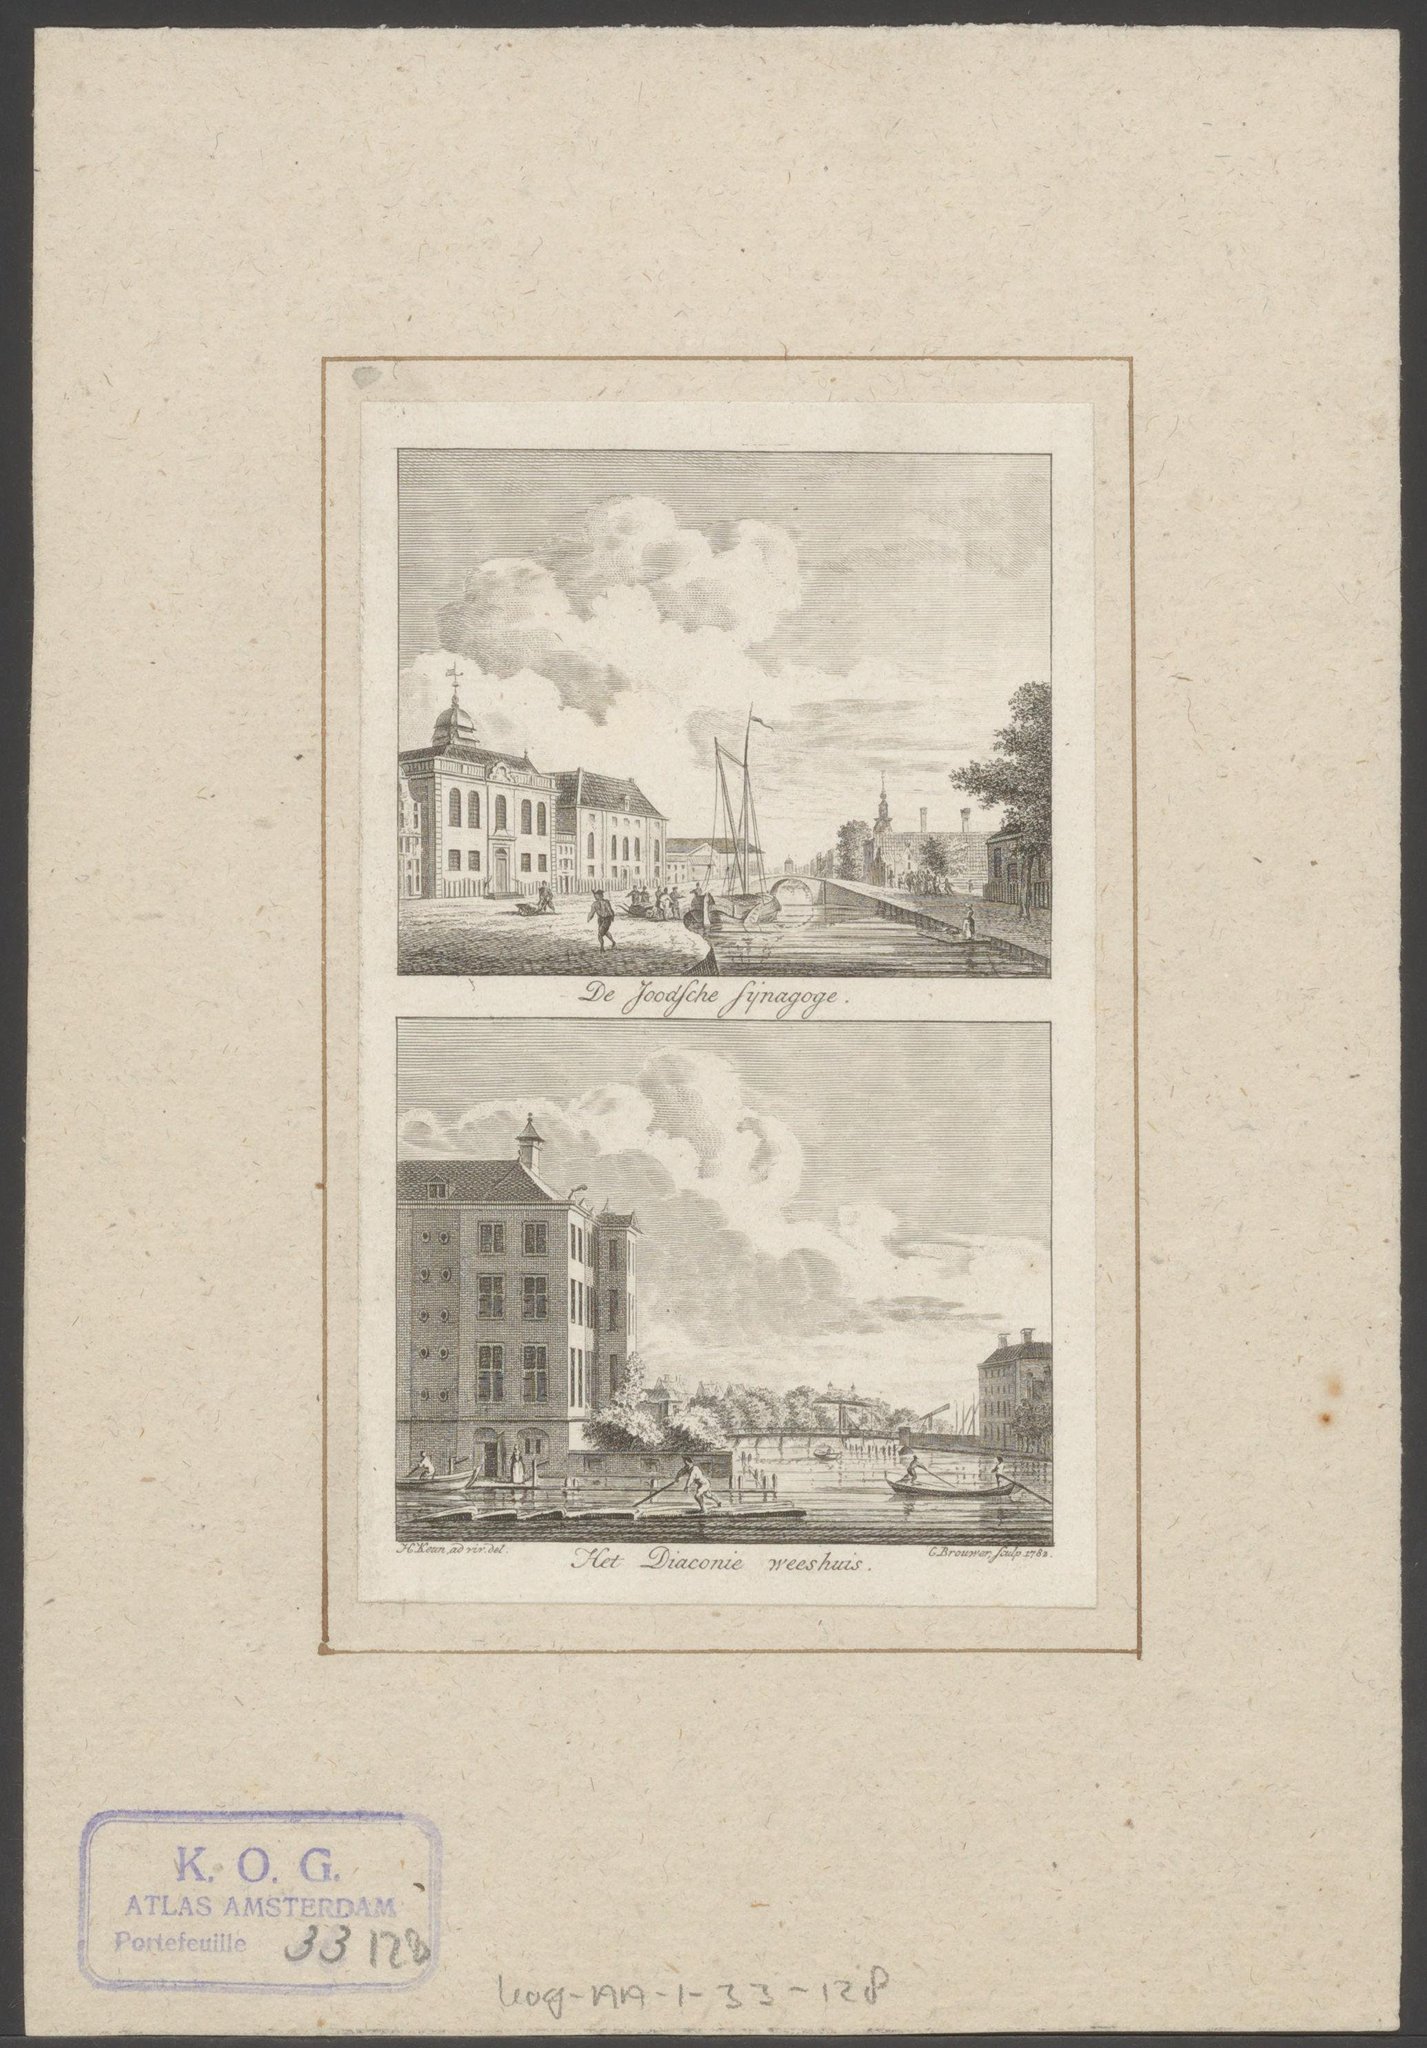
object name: print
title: De Joodsche Synagoge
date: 1782-1788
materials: paper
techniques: etching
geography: amsterdam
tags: sailing-ship, sailing-boat, the synagogue (as building and place of worship ~ jewish religion), rowing-boat, canoe, etc., orphanage, canals, waters (in city) (+ city(-scape) with figures, staffage)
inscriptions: collector's mark: Lugt 1641b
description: Prent mogelijk uit: Beschryving van Amsterdam verkort. Amsterdam: Hendrik Gartman en Izaak de Jongh, 1782. Of uit: Beschryving van Amsterdam verkort. Amsterdam: Johannes Wessing Willemsz. en Johannes van der Hey, 1788.